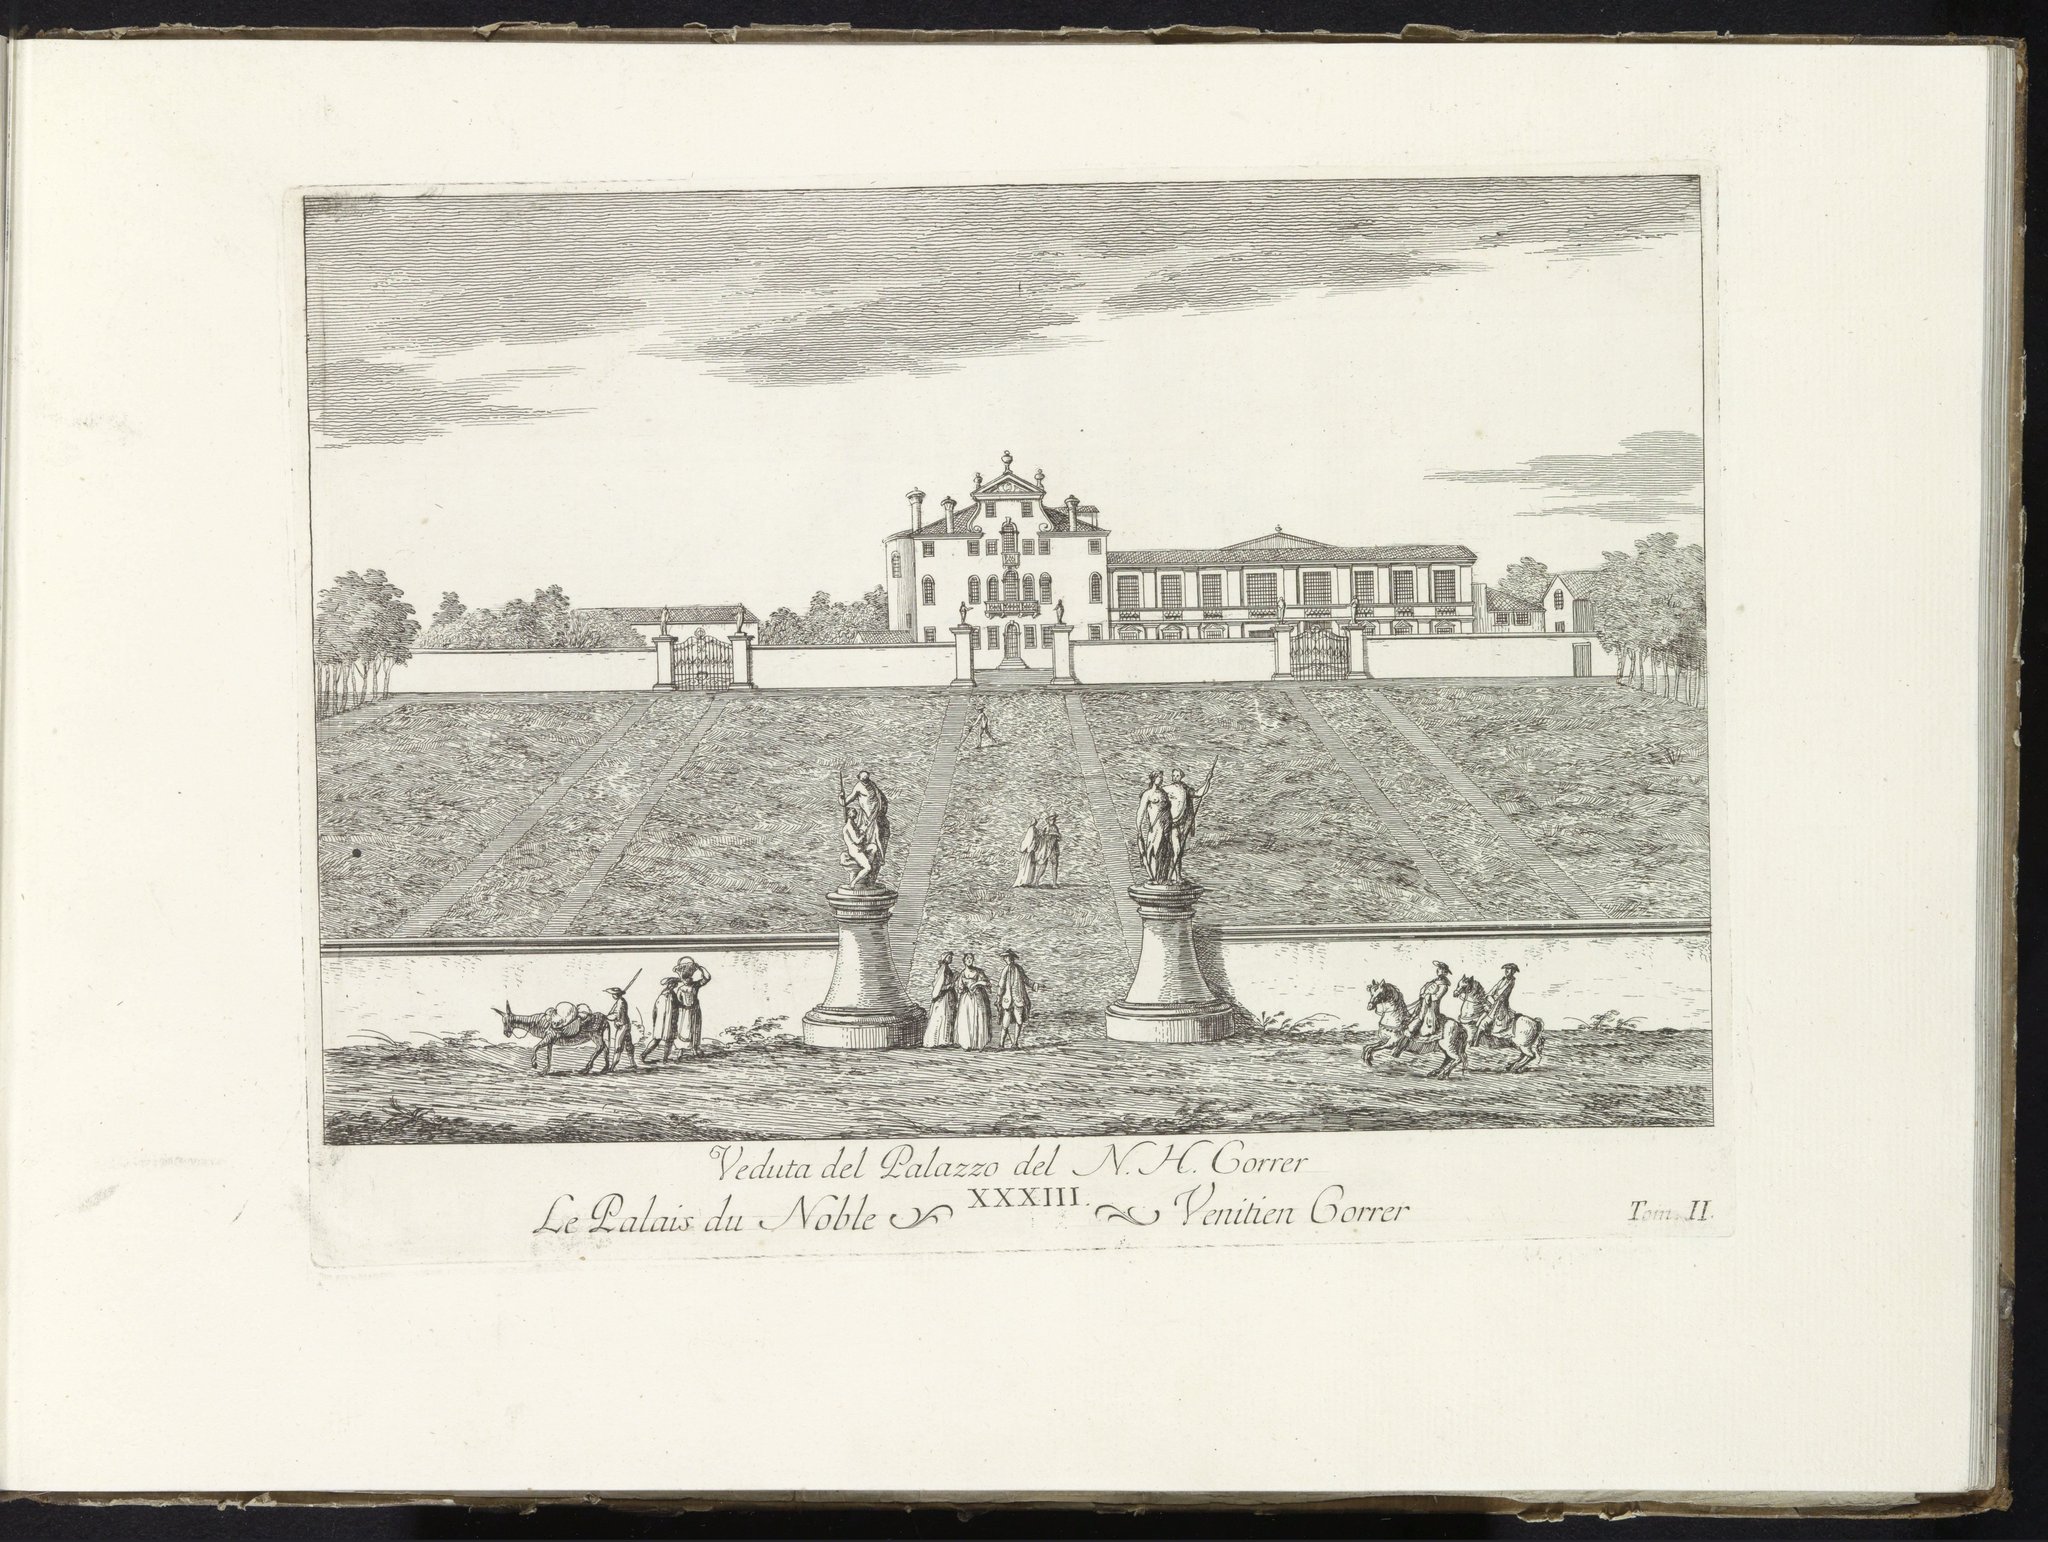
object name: print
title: Les delices de la Brenta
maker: giovanni francesco costa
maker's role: draughtsman, painter, print maker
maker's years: -1773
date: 1750-1760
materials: paper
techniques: etching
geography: venice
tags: garden, hôtel, i.e. small palace in city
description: Gezicht op Palazzo del N. H. Correr. Voor het paleis een met een muur omheinde tuin. Genummerd midden onder: XXXIII en rechtsonder: Tom: II. Deze prent maakt deel uit van een album.